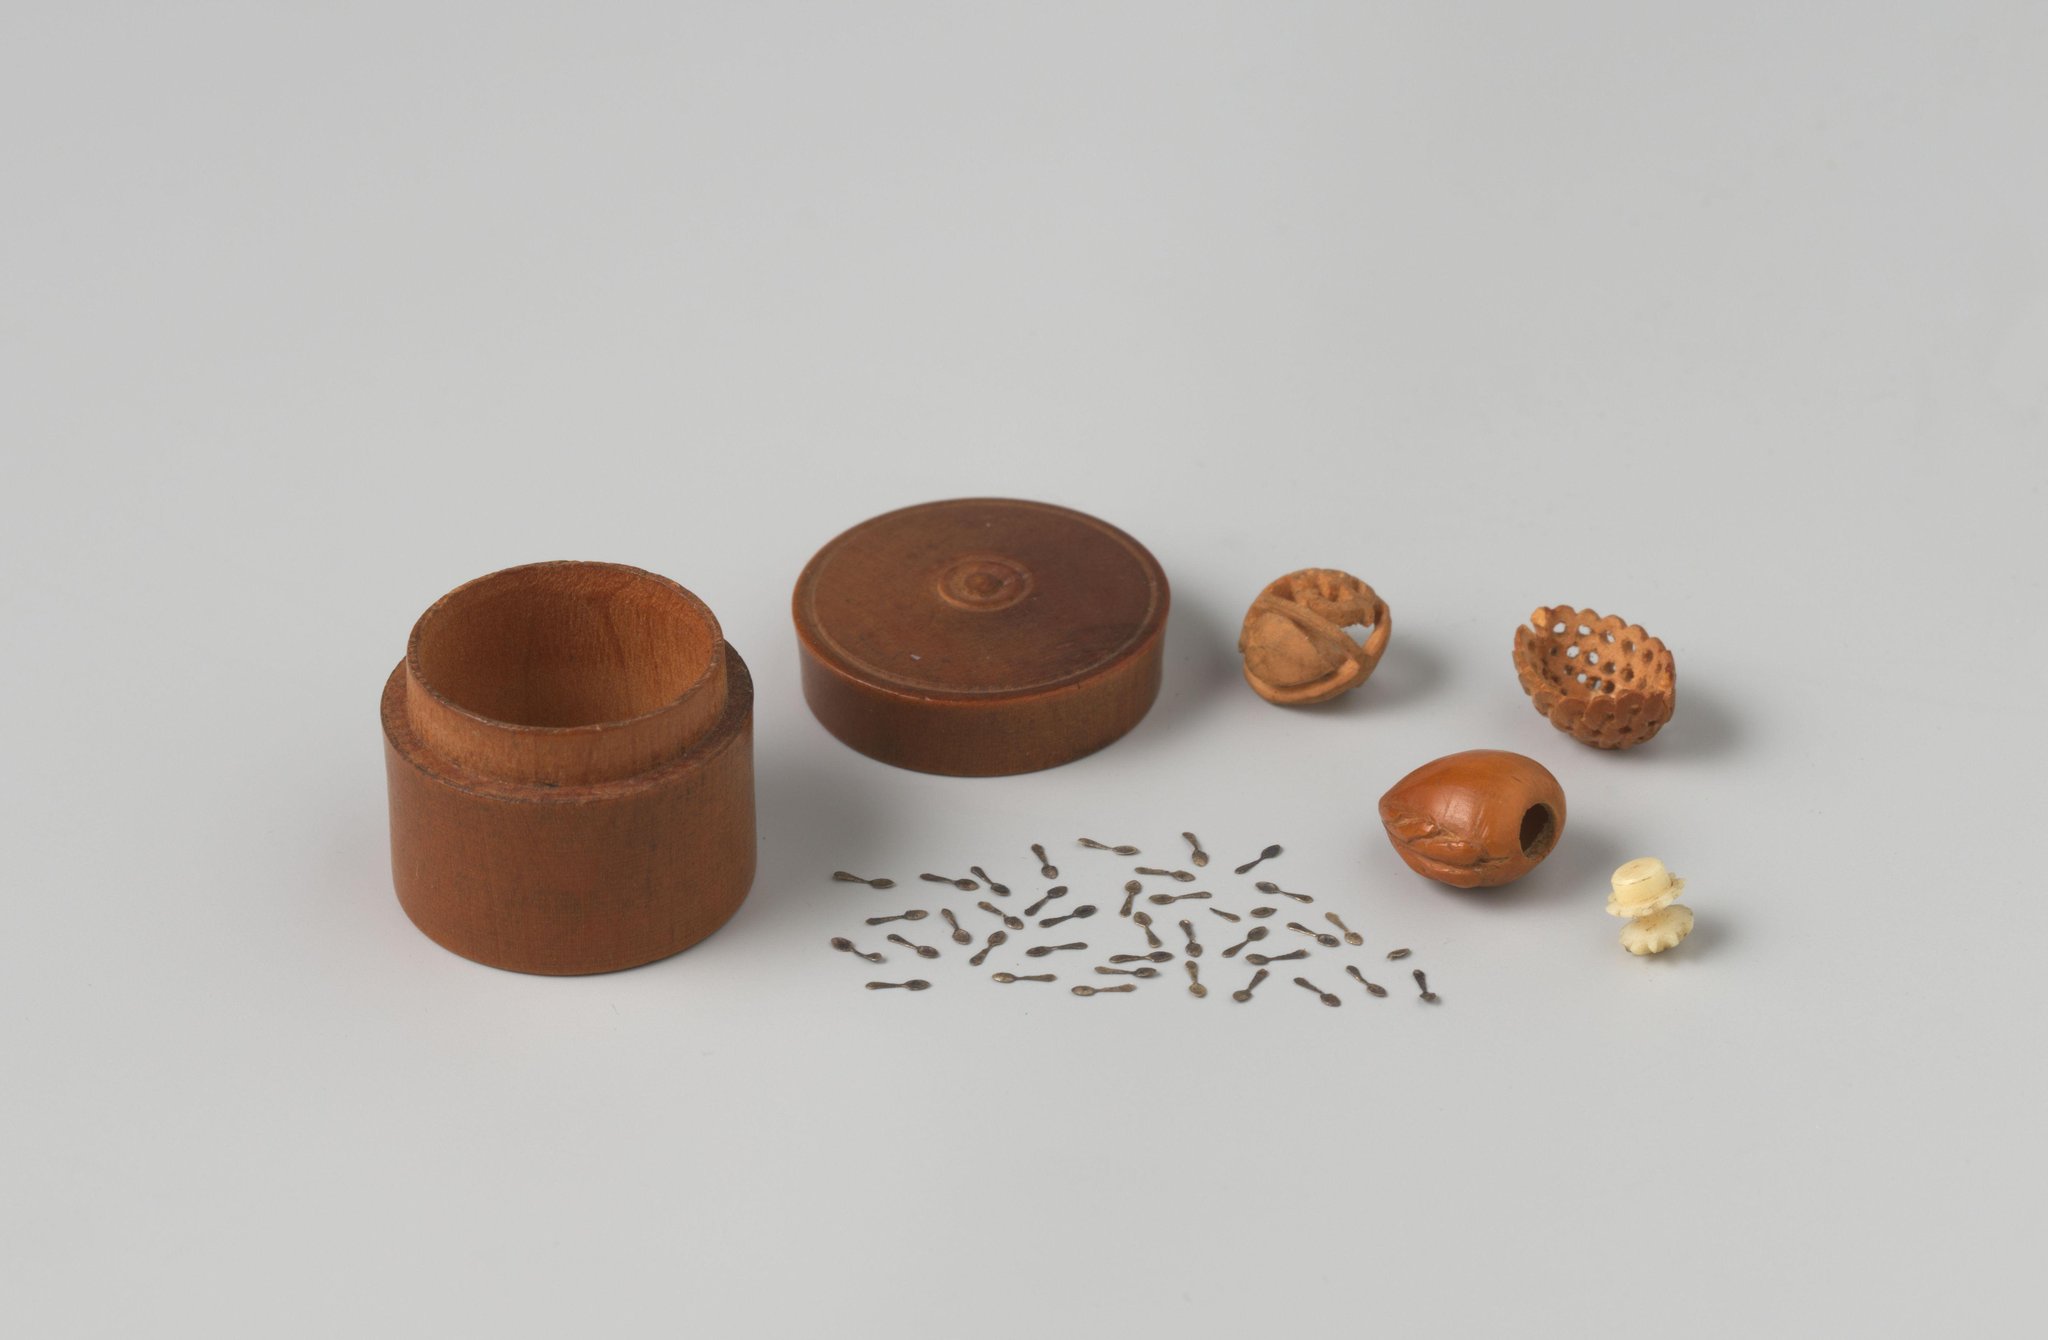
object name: basket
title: Doos met curiositeiten, waaronder 37 zilveren lepels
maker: Anonymous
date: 1600-1699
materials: wood, ivory, silver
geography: southern germany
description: Ronde doos met deksel, gedraaid van palmhout. Het platte deksel met drie gegroefde cirkels. De doos bevat drie kersenpitten: één gesneden tot een gevlochten mand, één gesneden tot een mand met een brandend hart en een anker, en één gesneden tot een doos met een ivoren knop, gevuld met 37 lepels van zilver.